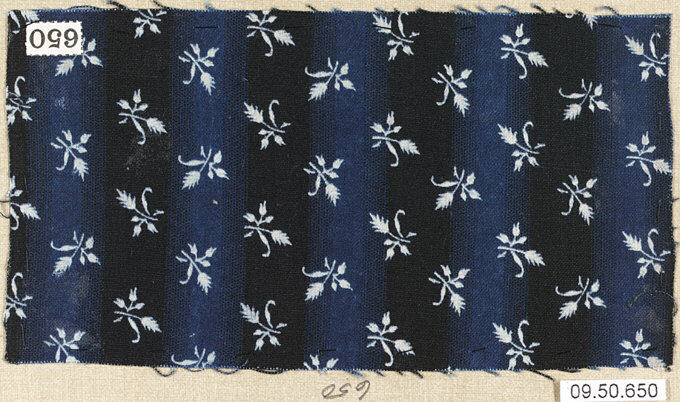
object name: piece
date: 1801-1900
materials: cotton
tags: leaves